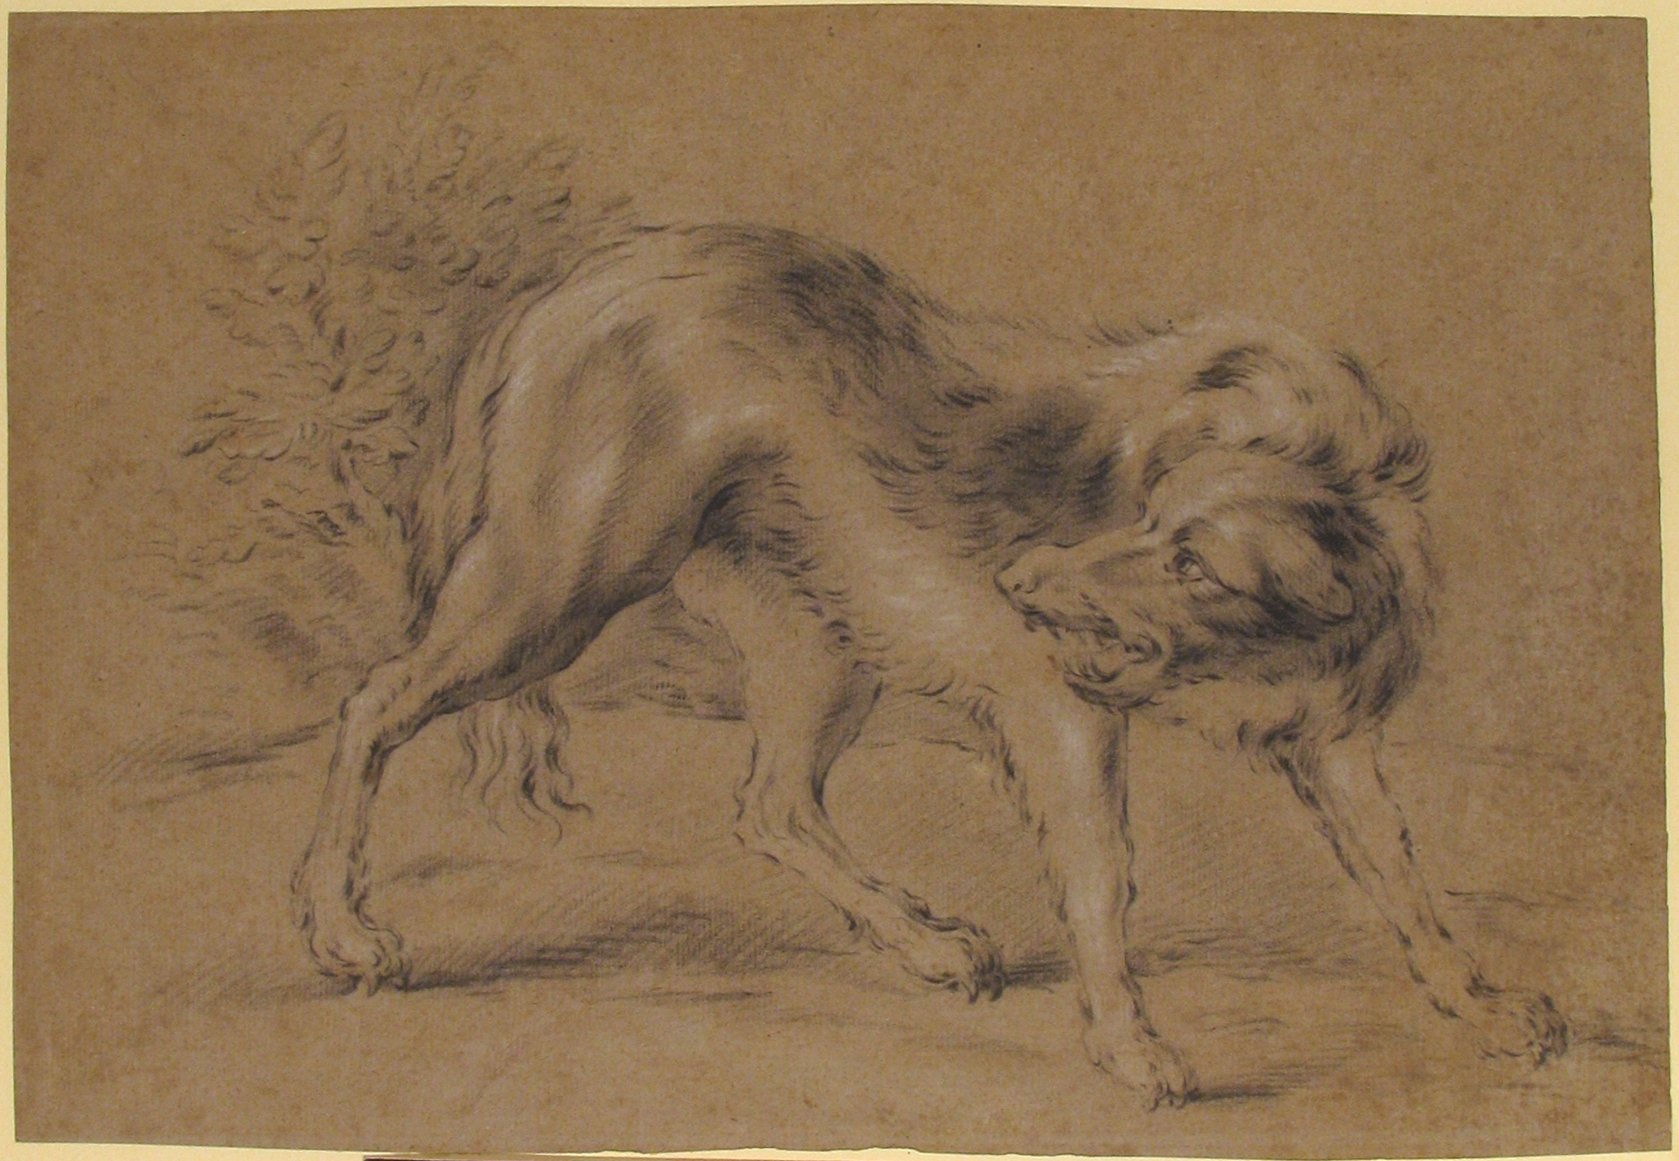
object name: drawing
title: Angry Dog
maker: jean-baptiste oudry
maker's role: artist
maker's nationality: french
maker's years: 1686-1755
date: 1701-1800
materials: chalk, paper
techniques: heightening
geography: france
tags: anger,dogs